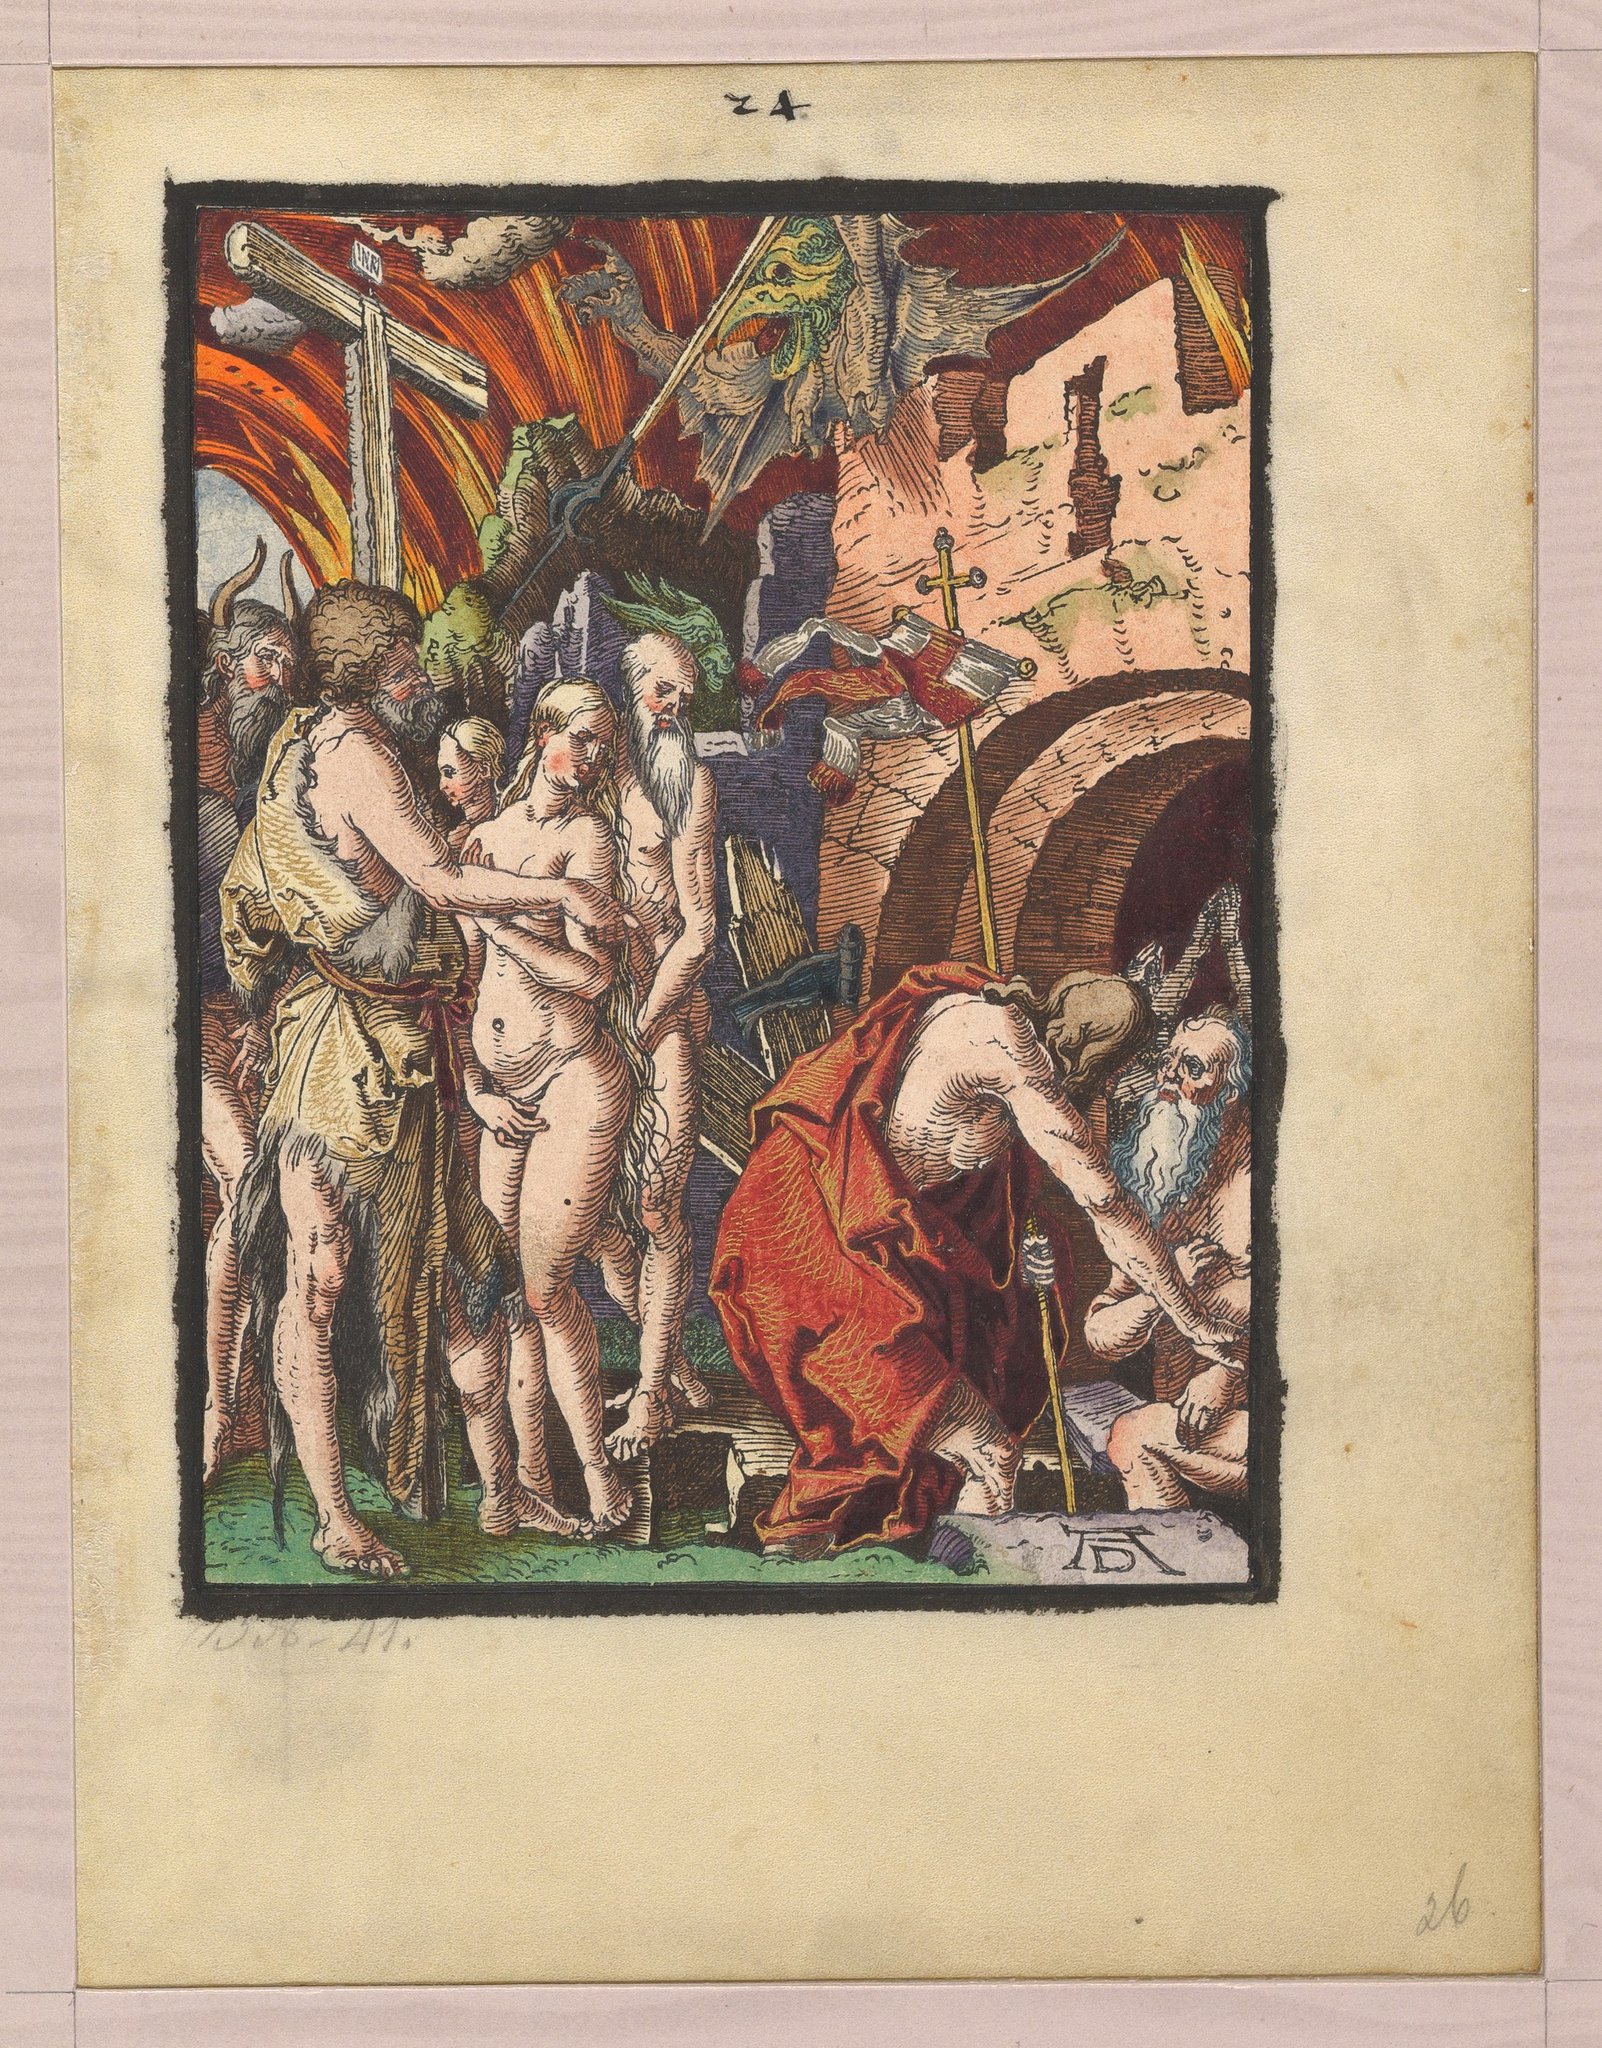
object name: print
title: Christ in Limbo, from "The Small Woodcut Passion"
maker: albrecht dürer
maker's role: artist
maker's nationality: german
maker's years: 1471-1528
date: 1509-1510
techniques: hand coloring, woodcut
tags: male nudes,female nudes,christ,cross